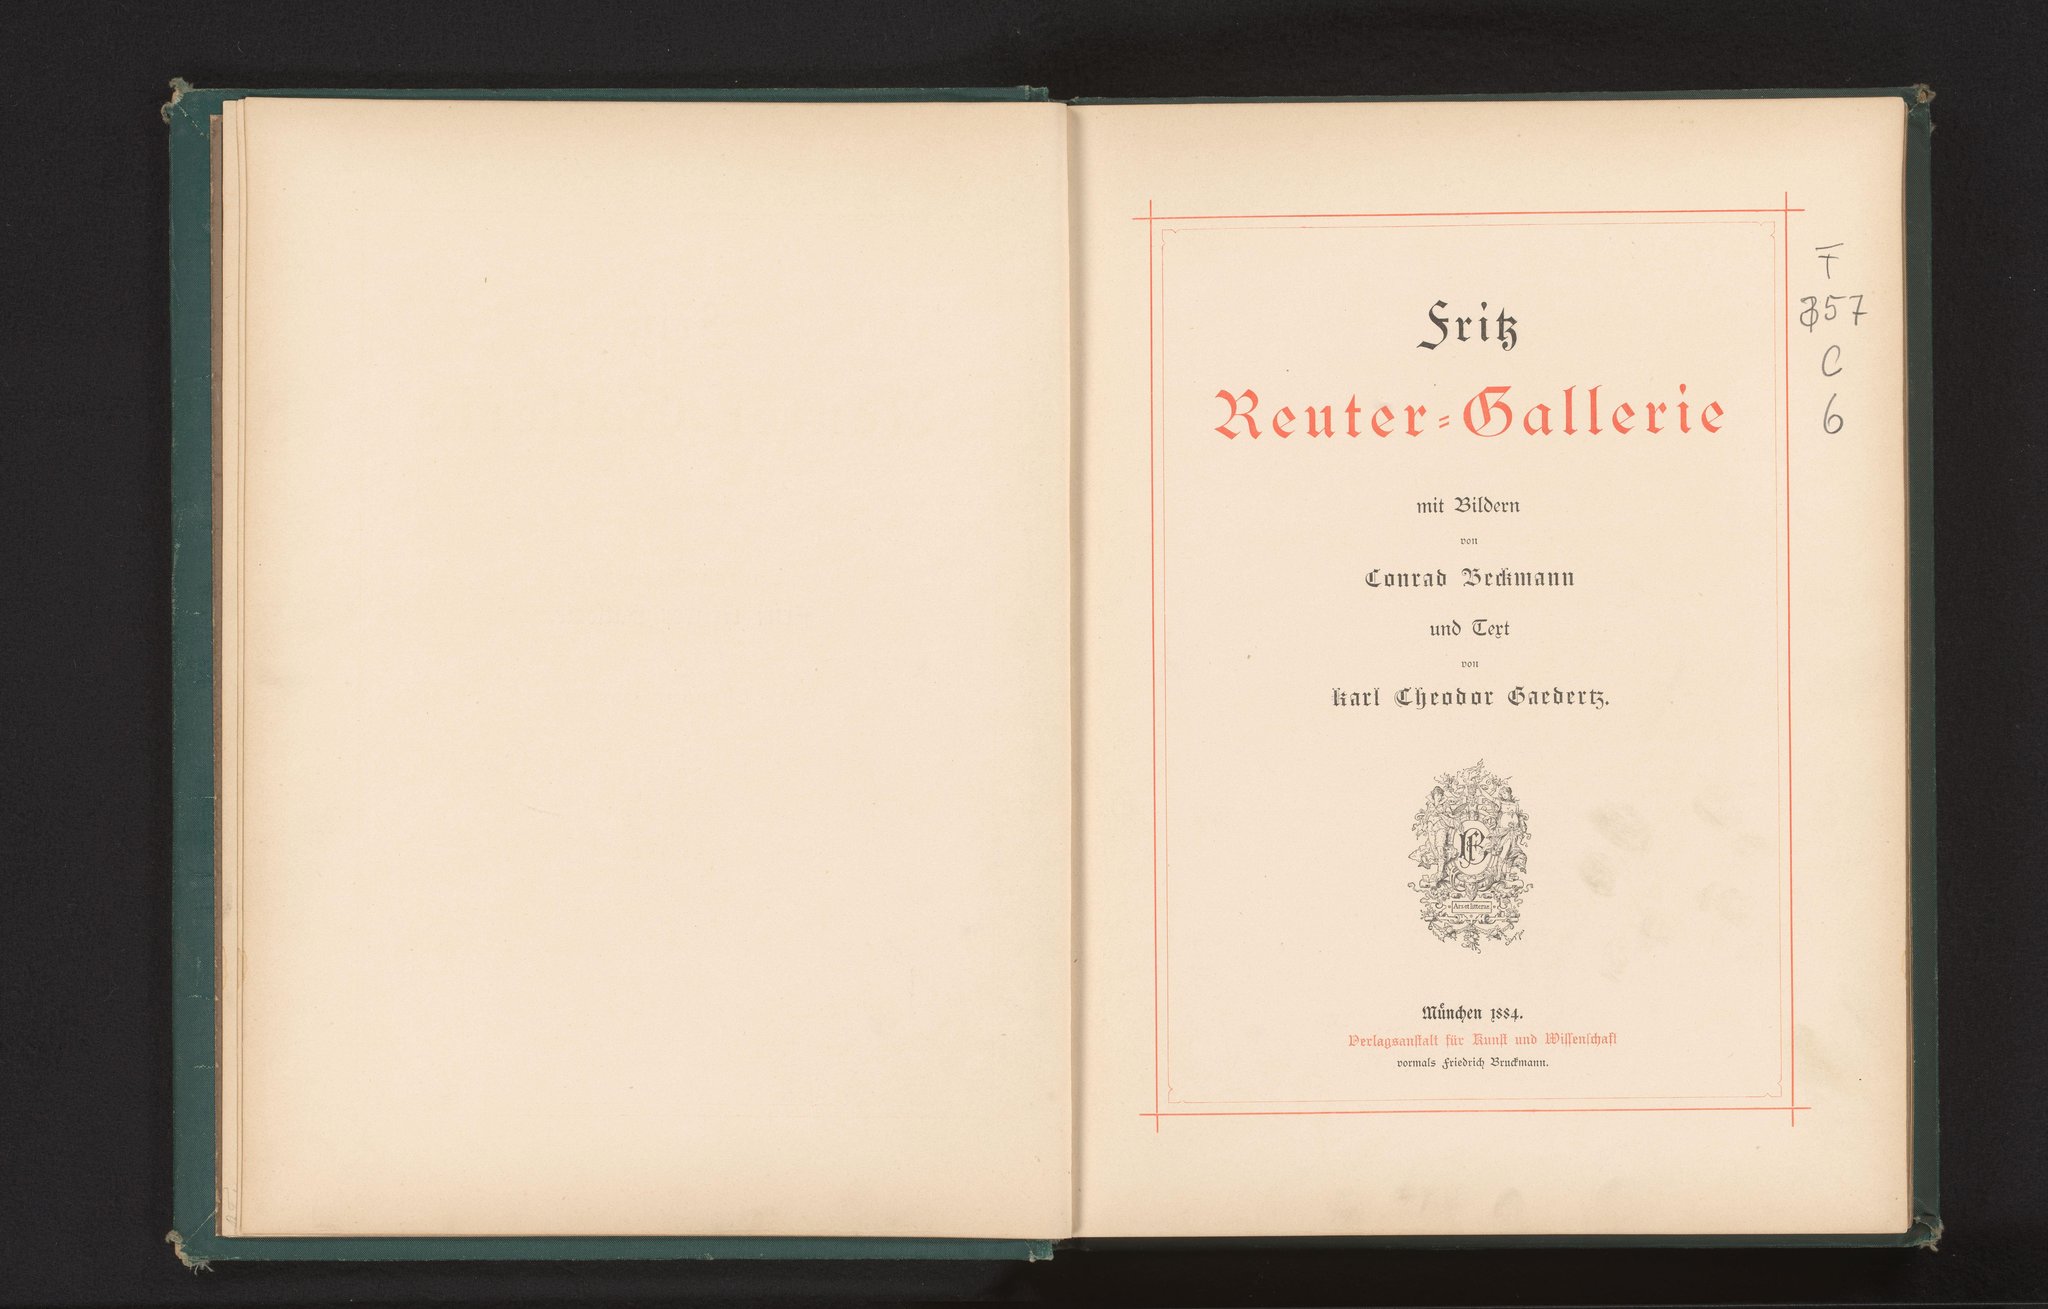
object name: book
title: Fritz Reuter-Gallerie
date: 1884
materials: cardboard, linen, paper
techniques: photograph, decorated paper